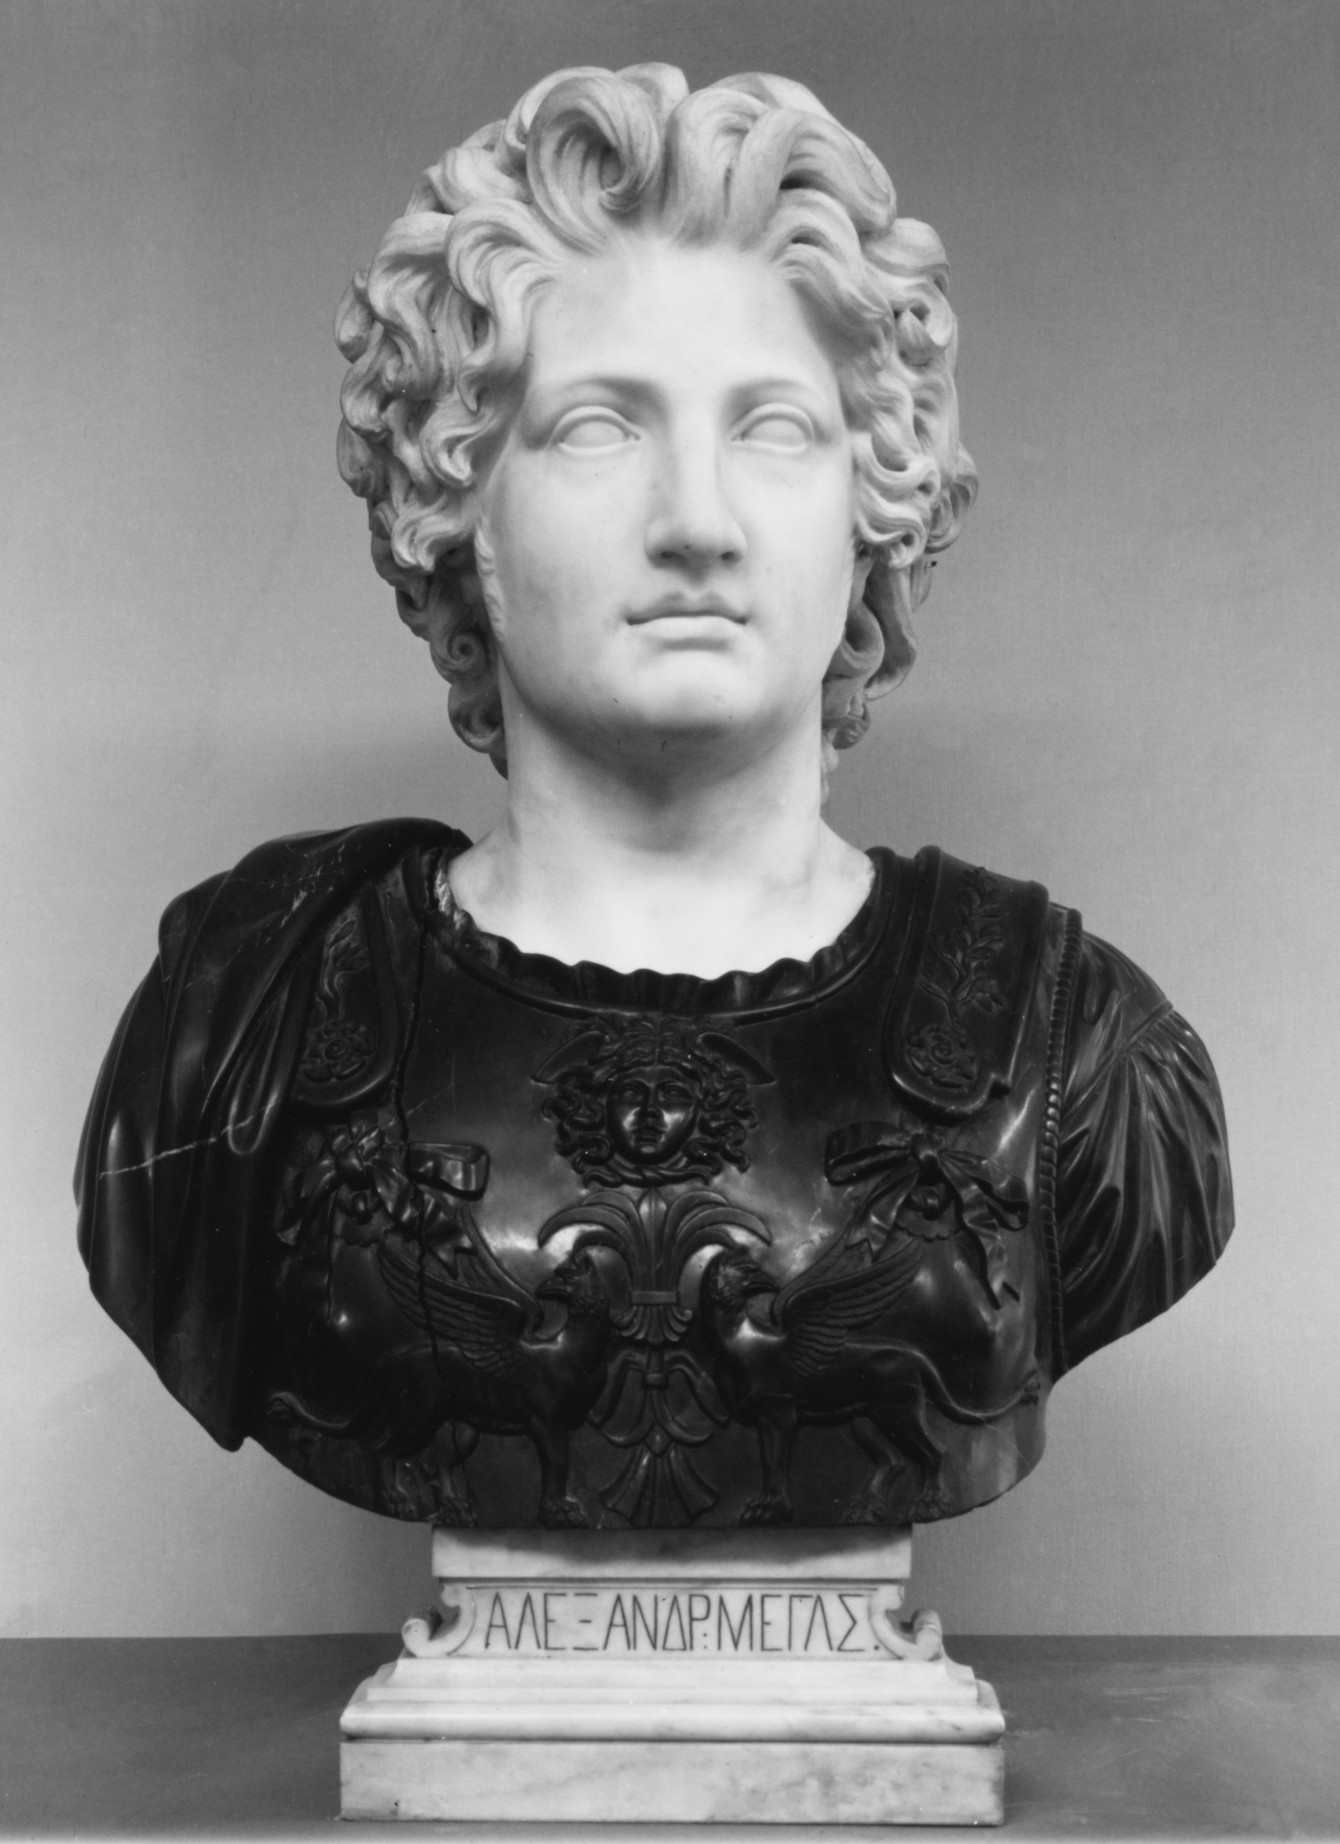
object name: bust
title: Alexander the Great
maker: viktor brodzki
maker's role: artist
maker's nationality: polish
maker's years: 1825-1904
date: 1801-1900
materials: marble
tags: alexander the great,men,portraits